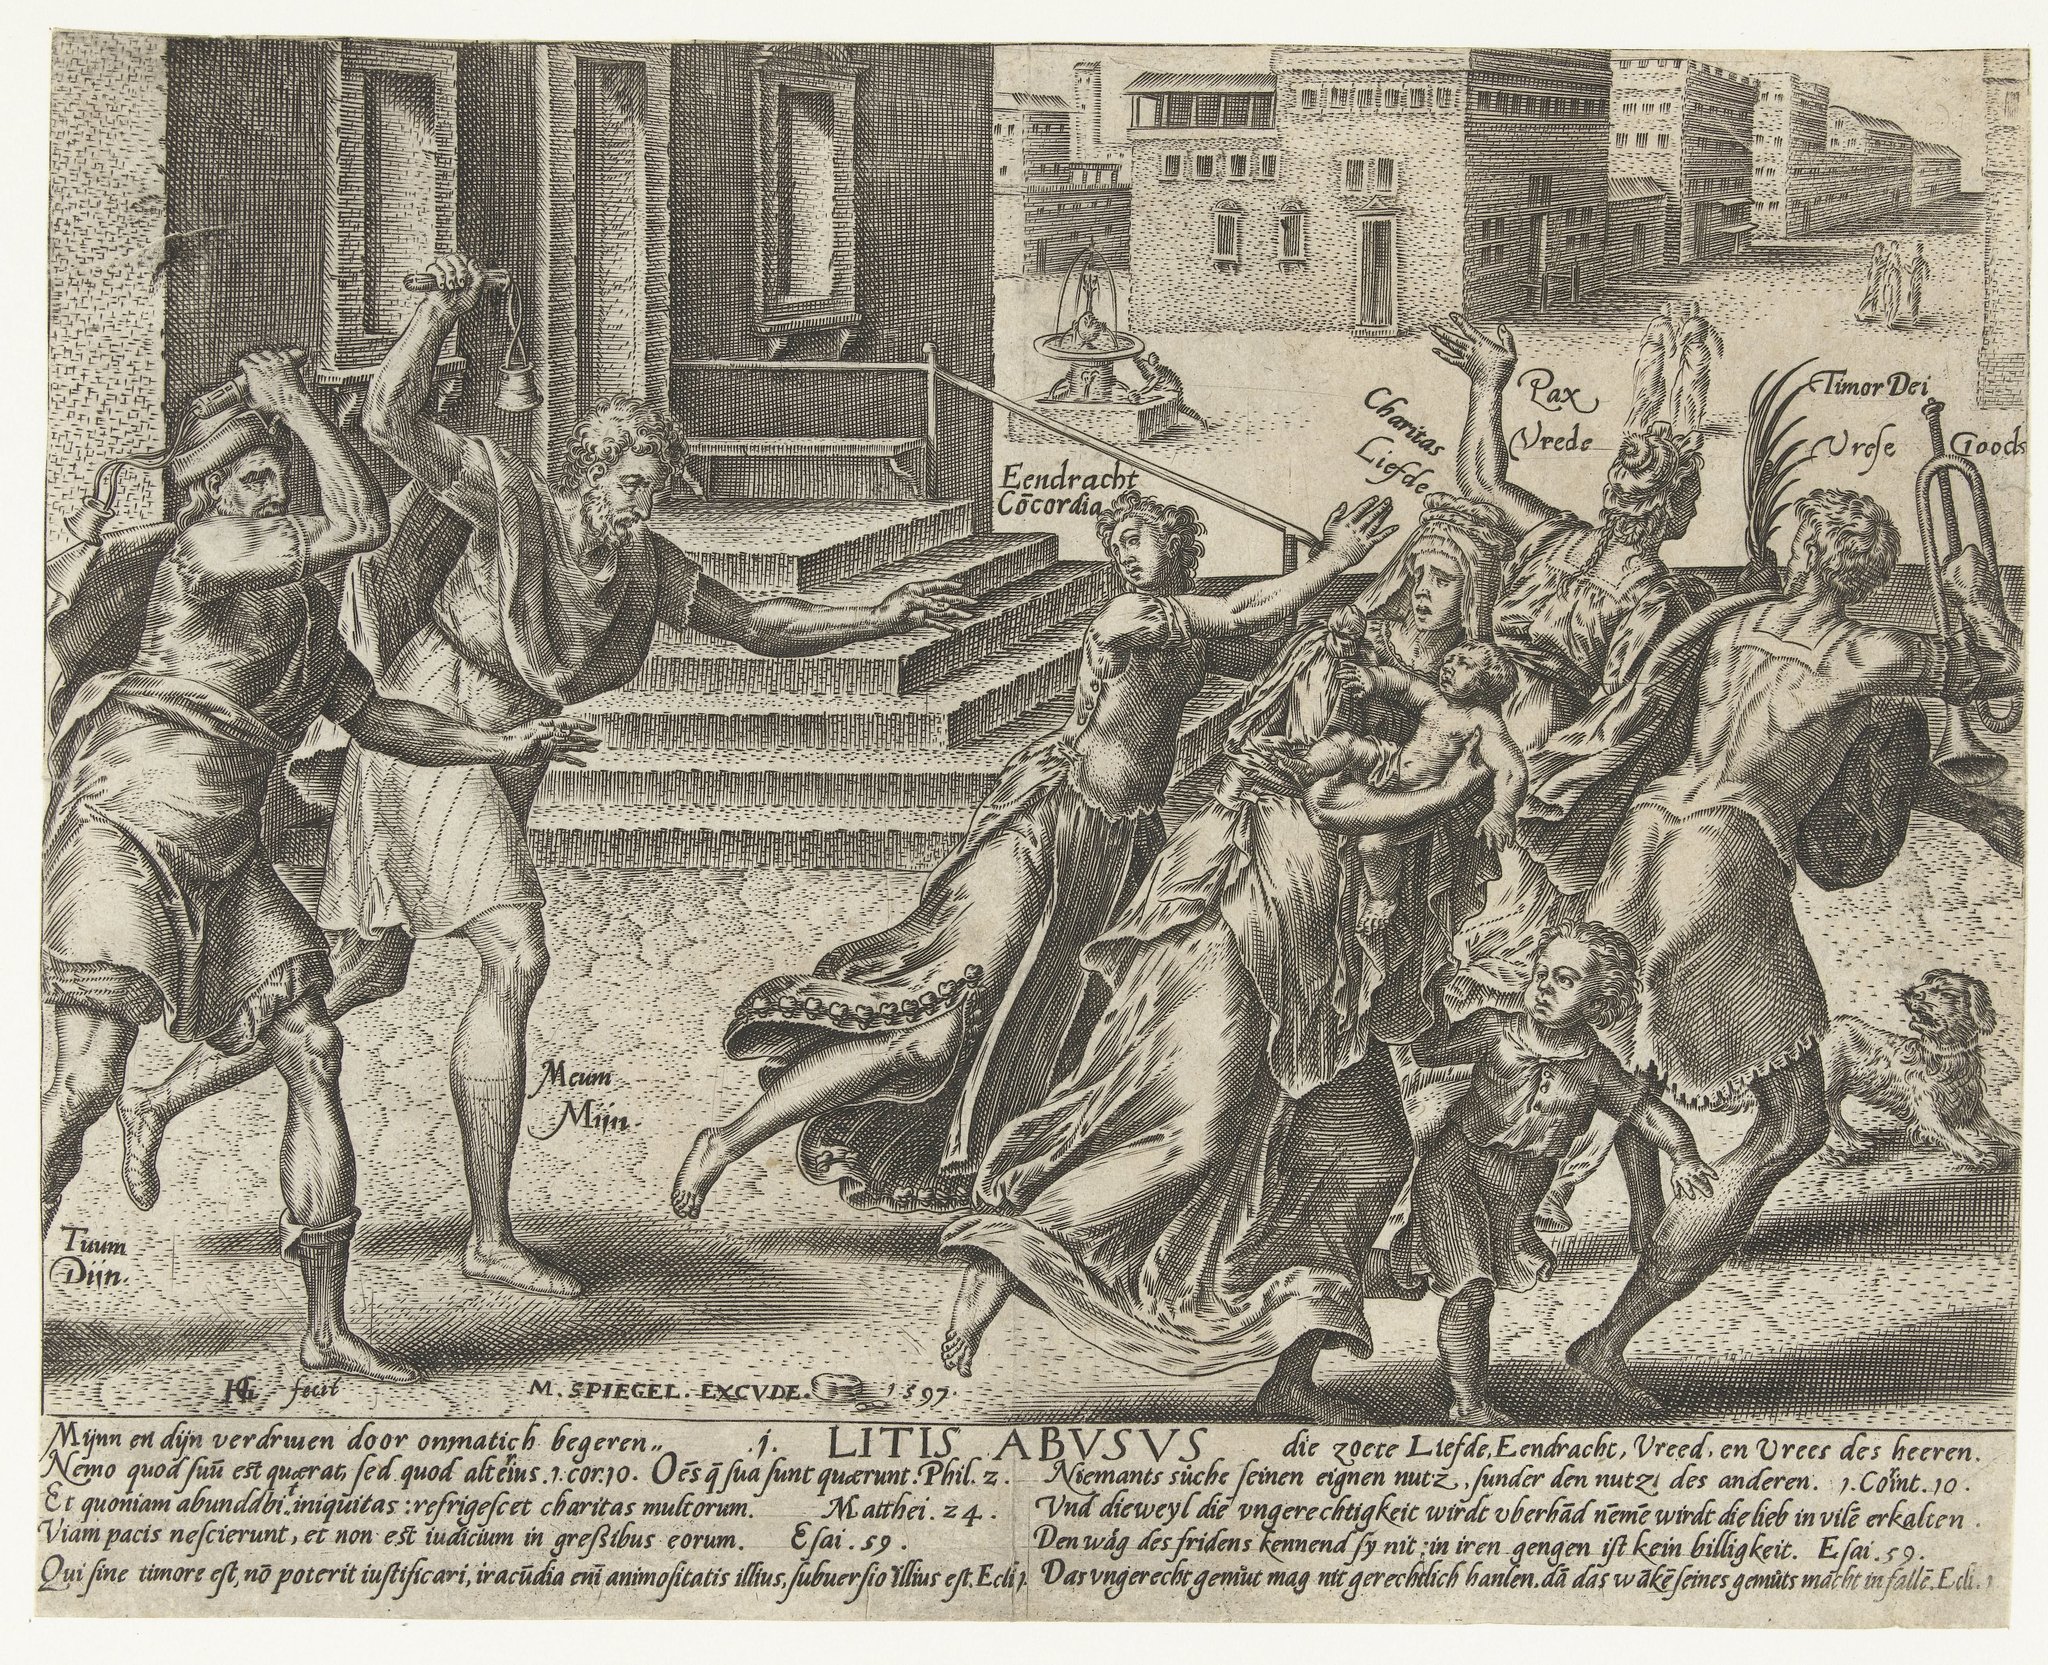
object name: print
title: Mijn en dijn verjagen Eendracht, Liefde, Vrede en Vreze Gods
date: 1597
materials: paper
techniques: engraving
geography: low countries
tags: charity, 'caritas'; 'carità' (ripa) ~ one of the three theological virtues, concordia as roman personification, pax as roman personification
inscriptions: collector's mark: Lugt 2228a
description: Allegorische voorstelling van de figuren Mijn en Dijn die de Eendracht, de Liefde, de Vrede en de Vreze Gods verdrijven. Uitvoerig onderschrift in Nederlands, Duits en Latijn. Deze prent is onderdeel van een serie van acht prenten over hebzucht, bedrog en procederen.